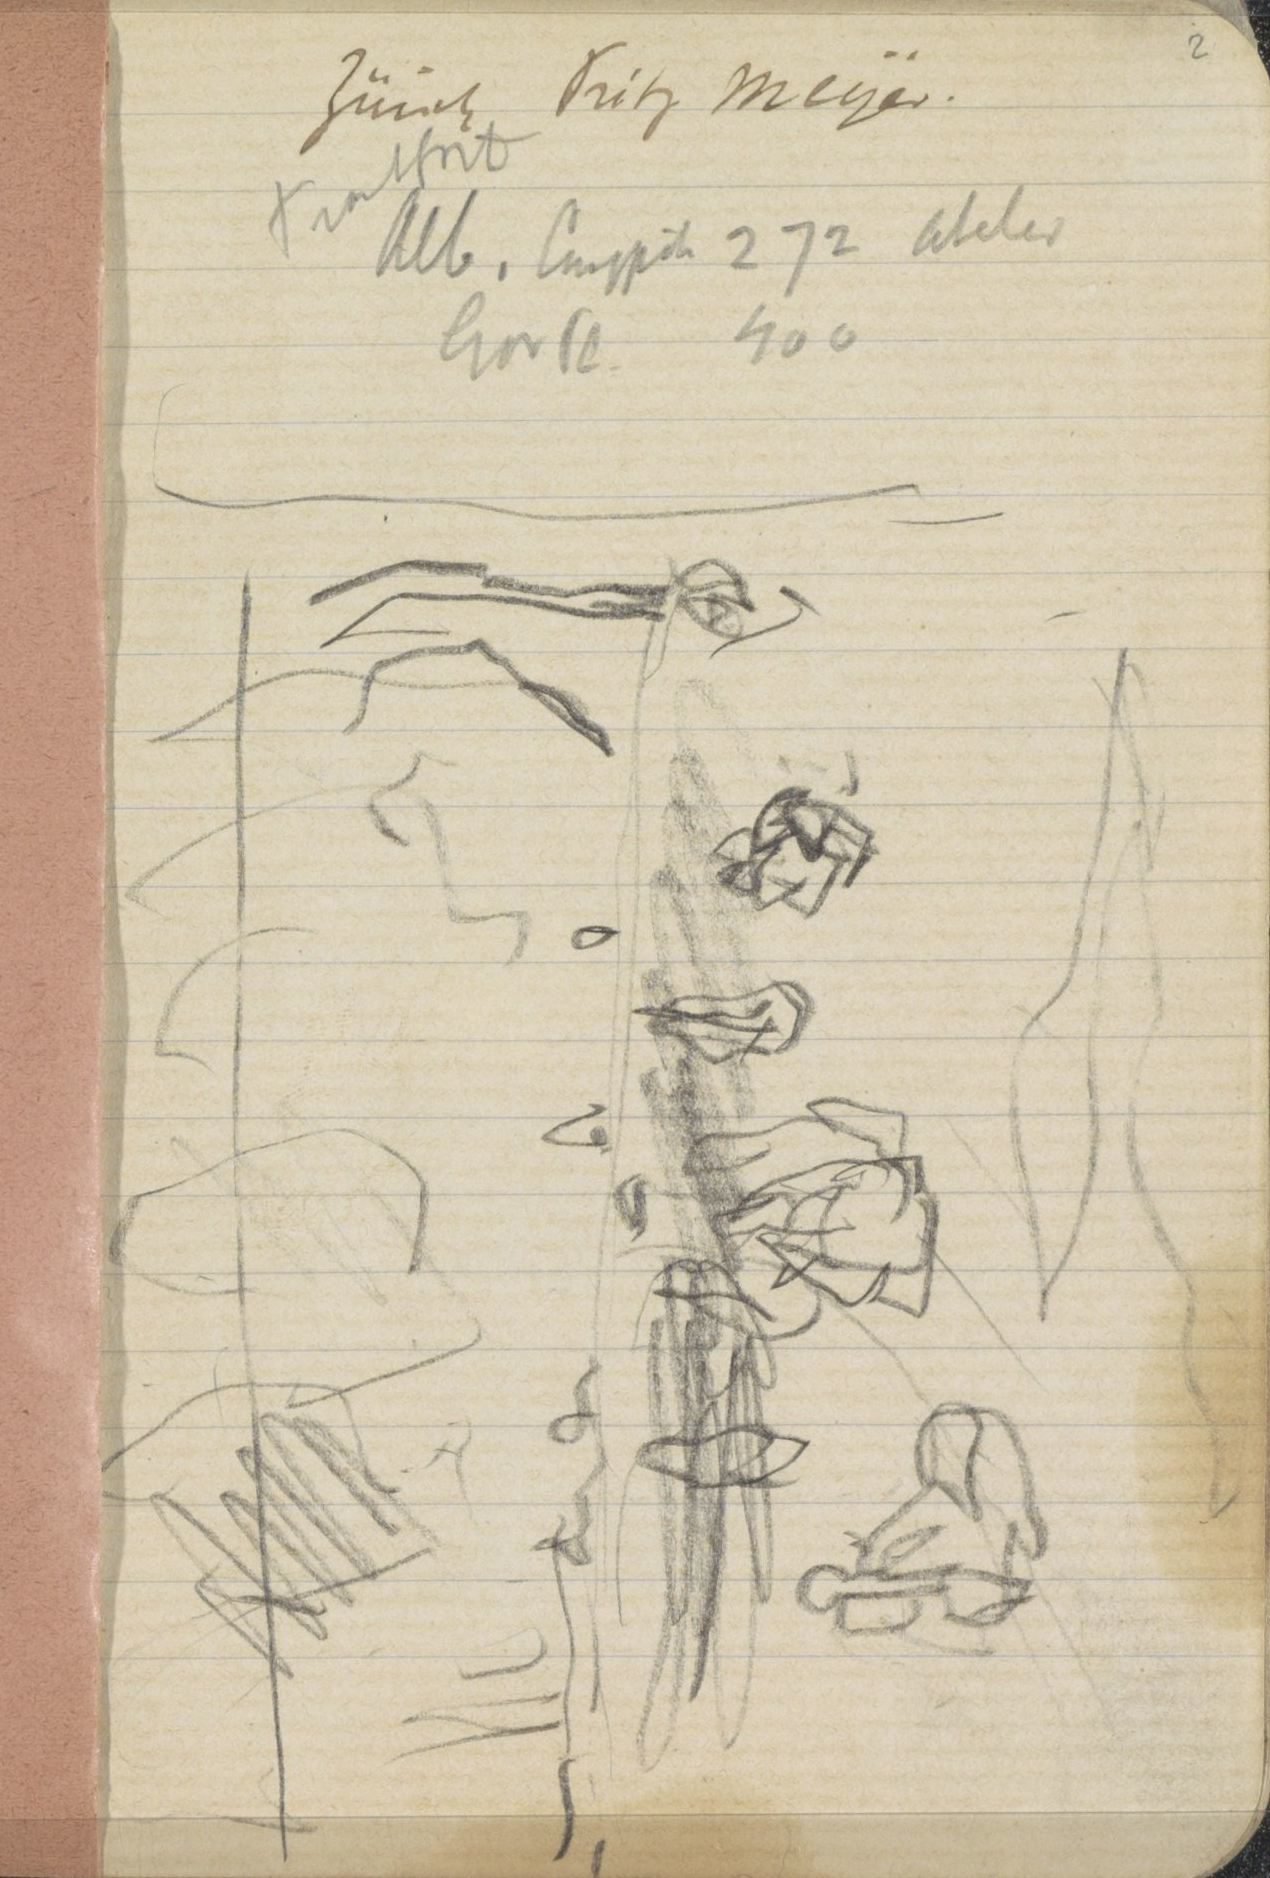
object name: sketchbook leaf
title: Compositiestudie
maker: george hendrik breitner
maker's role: draughtsman, painter, print maker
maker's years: 1857-1923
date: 1896-1901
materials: chalk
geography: amsterdam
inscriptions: annotation: ‘Zürich Fritz Meijer/ Frankfort/ Alb. Cuypstr. 272 atelier/ [...]’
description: Pagina 2 uit een schetsboek met 37 bladen.